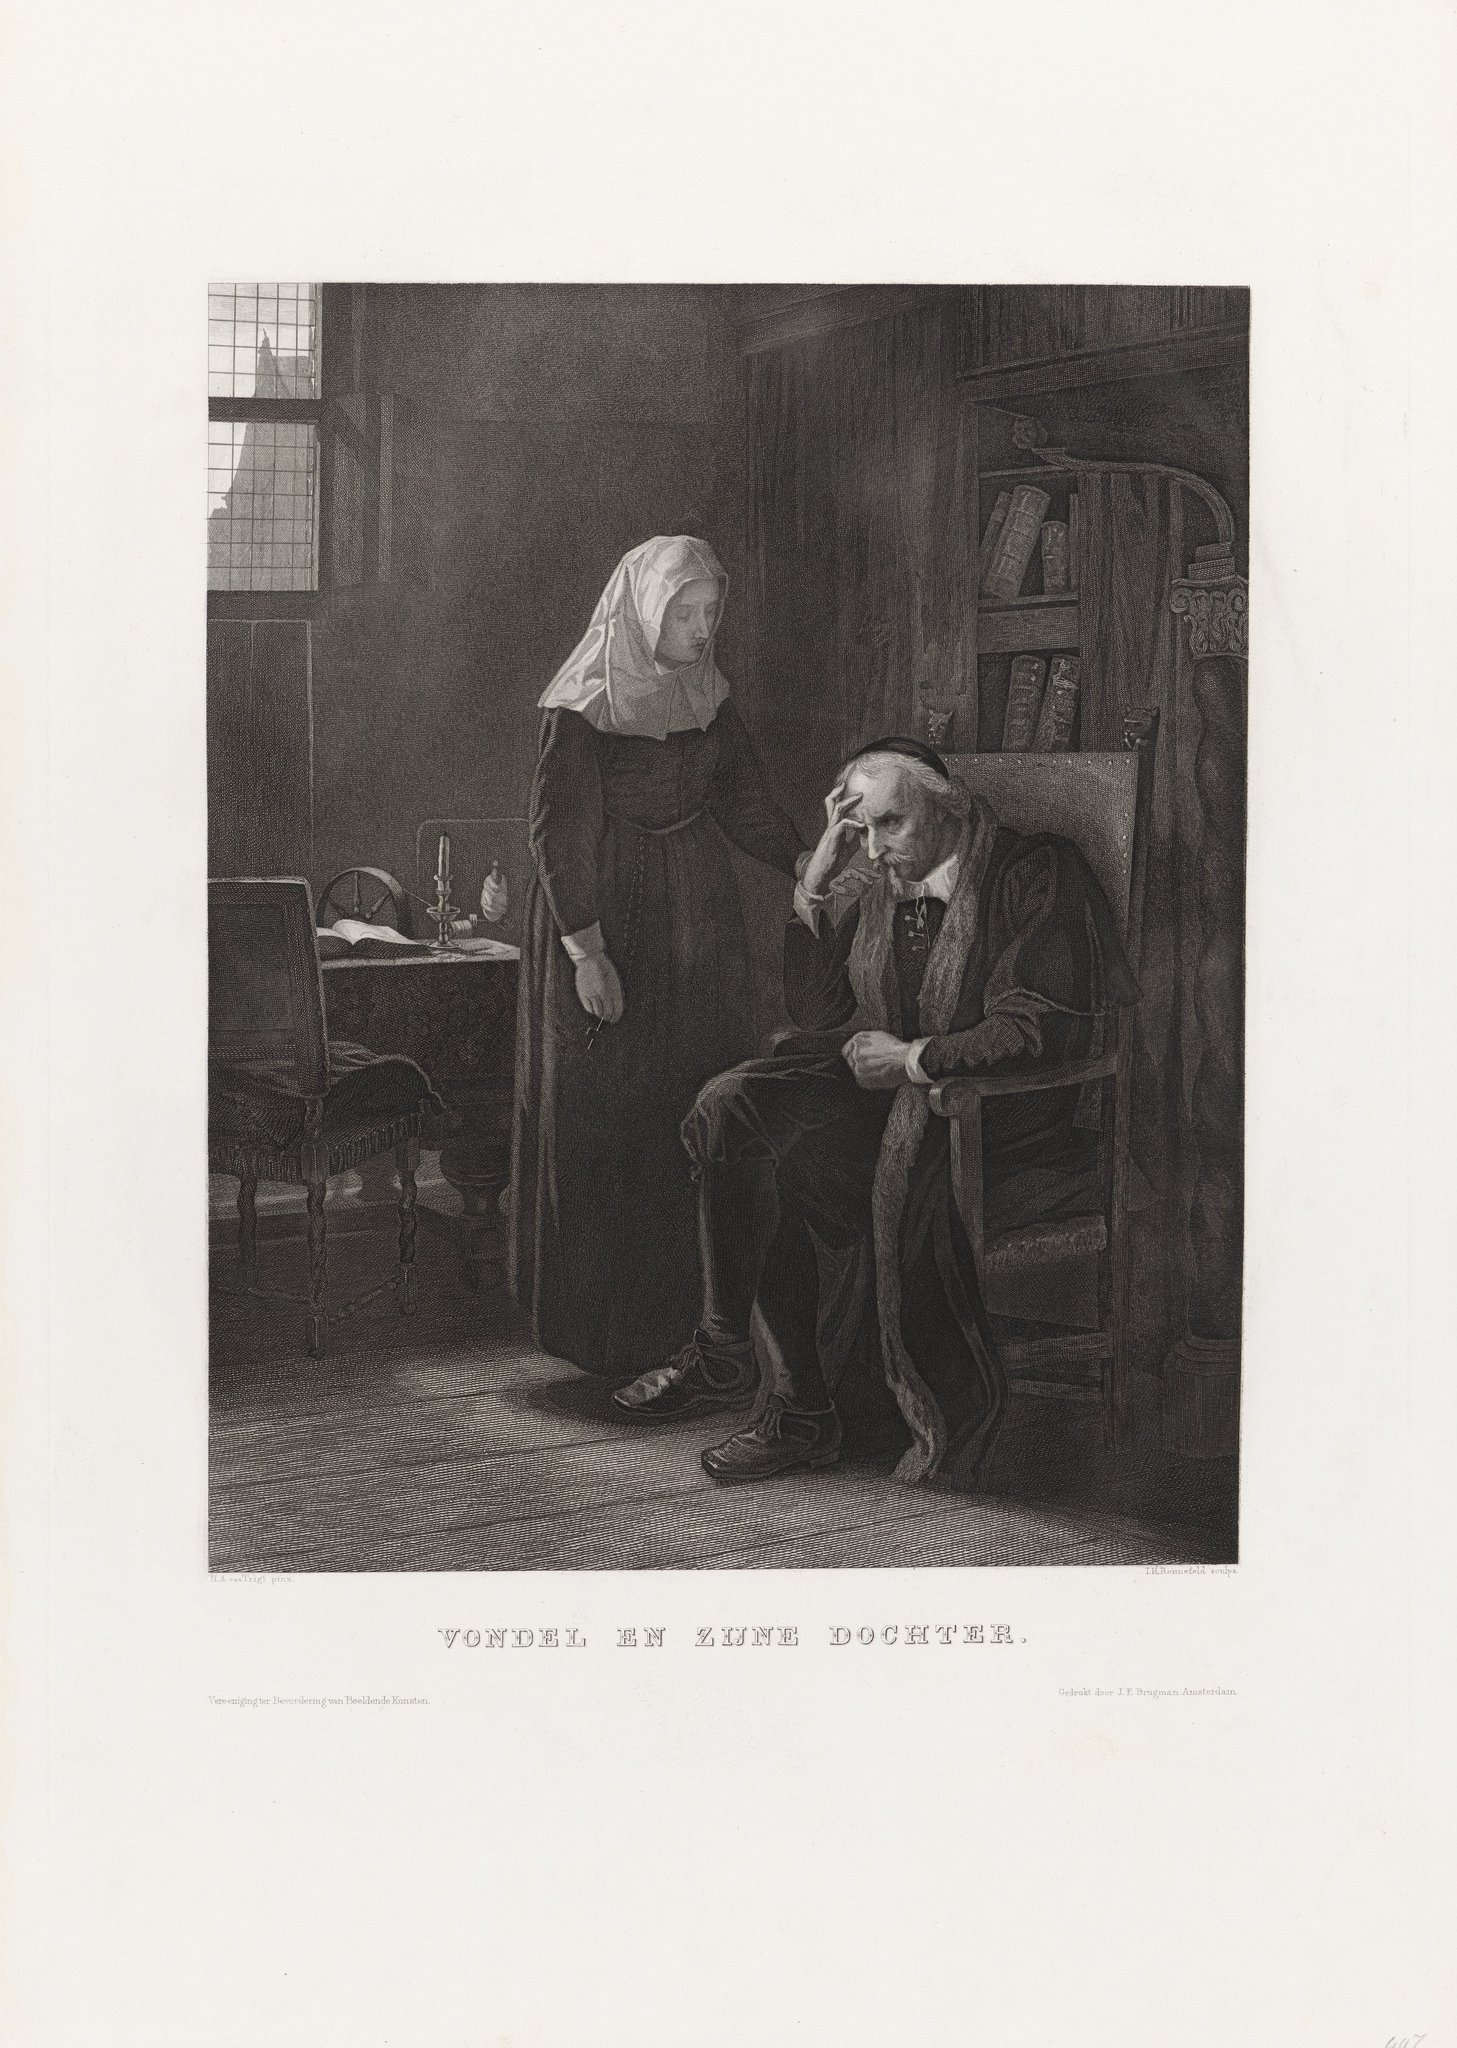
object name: print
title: Vondel en zijne dochter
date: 1860-1877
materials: paper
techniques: engraving, etching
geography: amsterdam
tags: cologne, amsterdam, joost van den vondel, brooding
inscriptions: collector's mark: Lugt 2228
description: In een vertrekt zit Joost van den Vondel peinzend op een stoel. Zijn dochter staat naast hem en raakt zijn schouder aan.